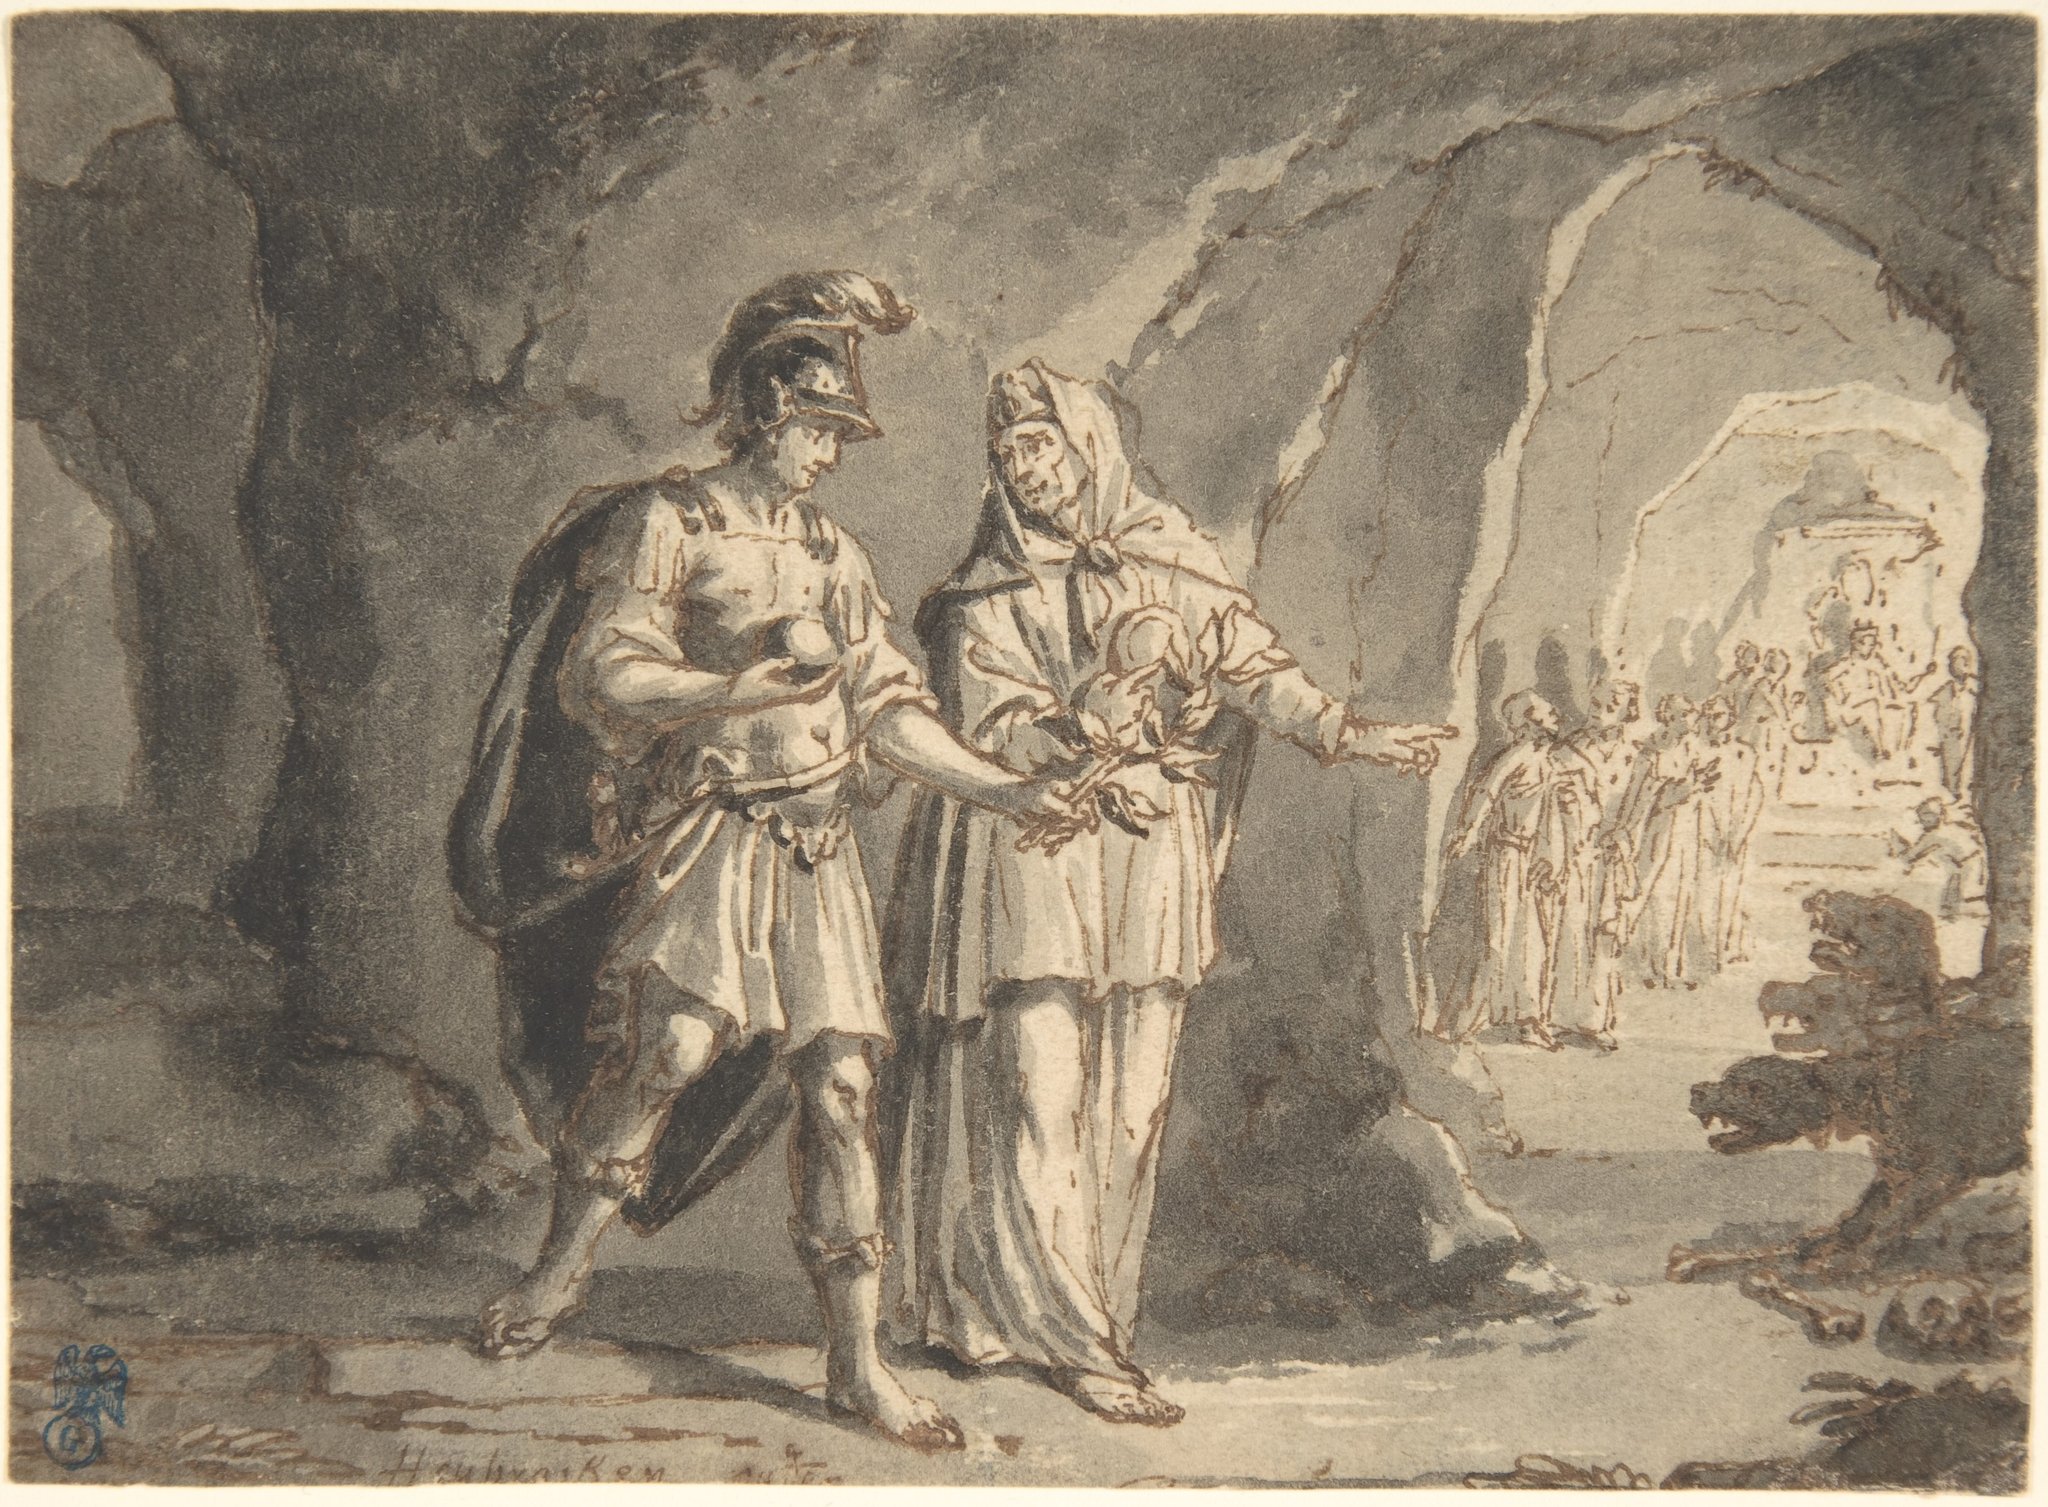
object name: drawing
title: Aeneas and the Sibyl in the Underworld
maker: arnold houbraken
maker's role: draughtsman, painter, print maker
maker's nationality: dutch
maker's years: 1660-1719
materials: ink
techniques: brush, pen, transfer, wash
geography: netherlands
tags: animals,aeneas,sibyl